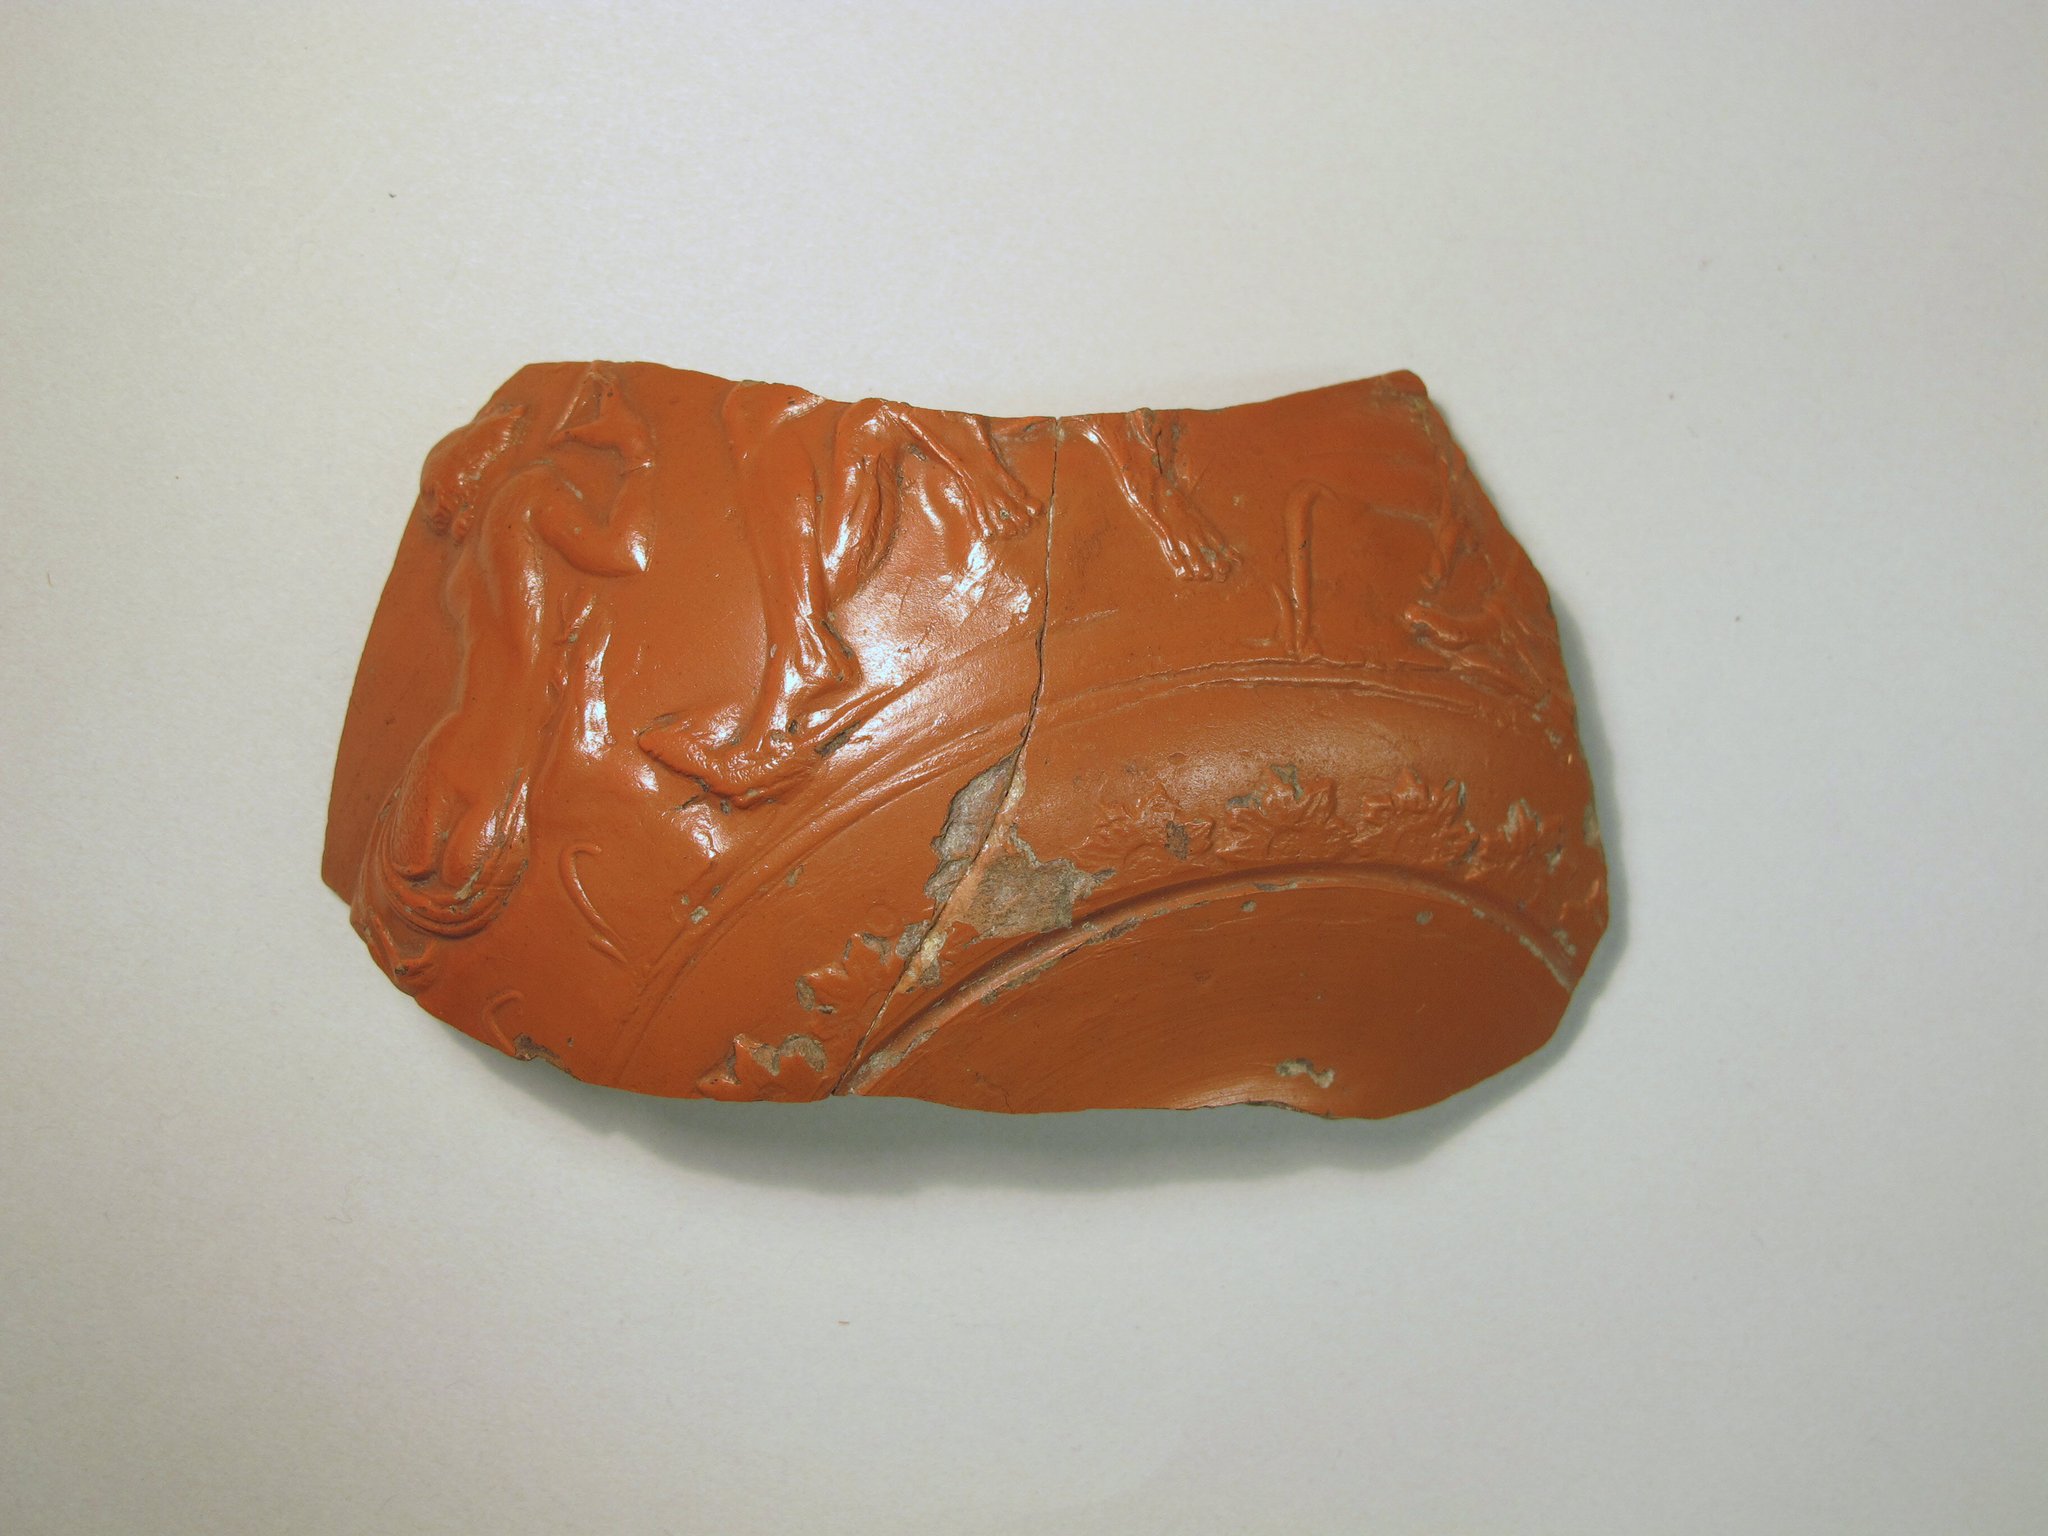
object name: vase fragment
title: Terracotta bowl fragment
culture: roman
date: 25-10 BCE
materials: terracotta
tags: feet,men,women